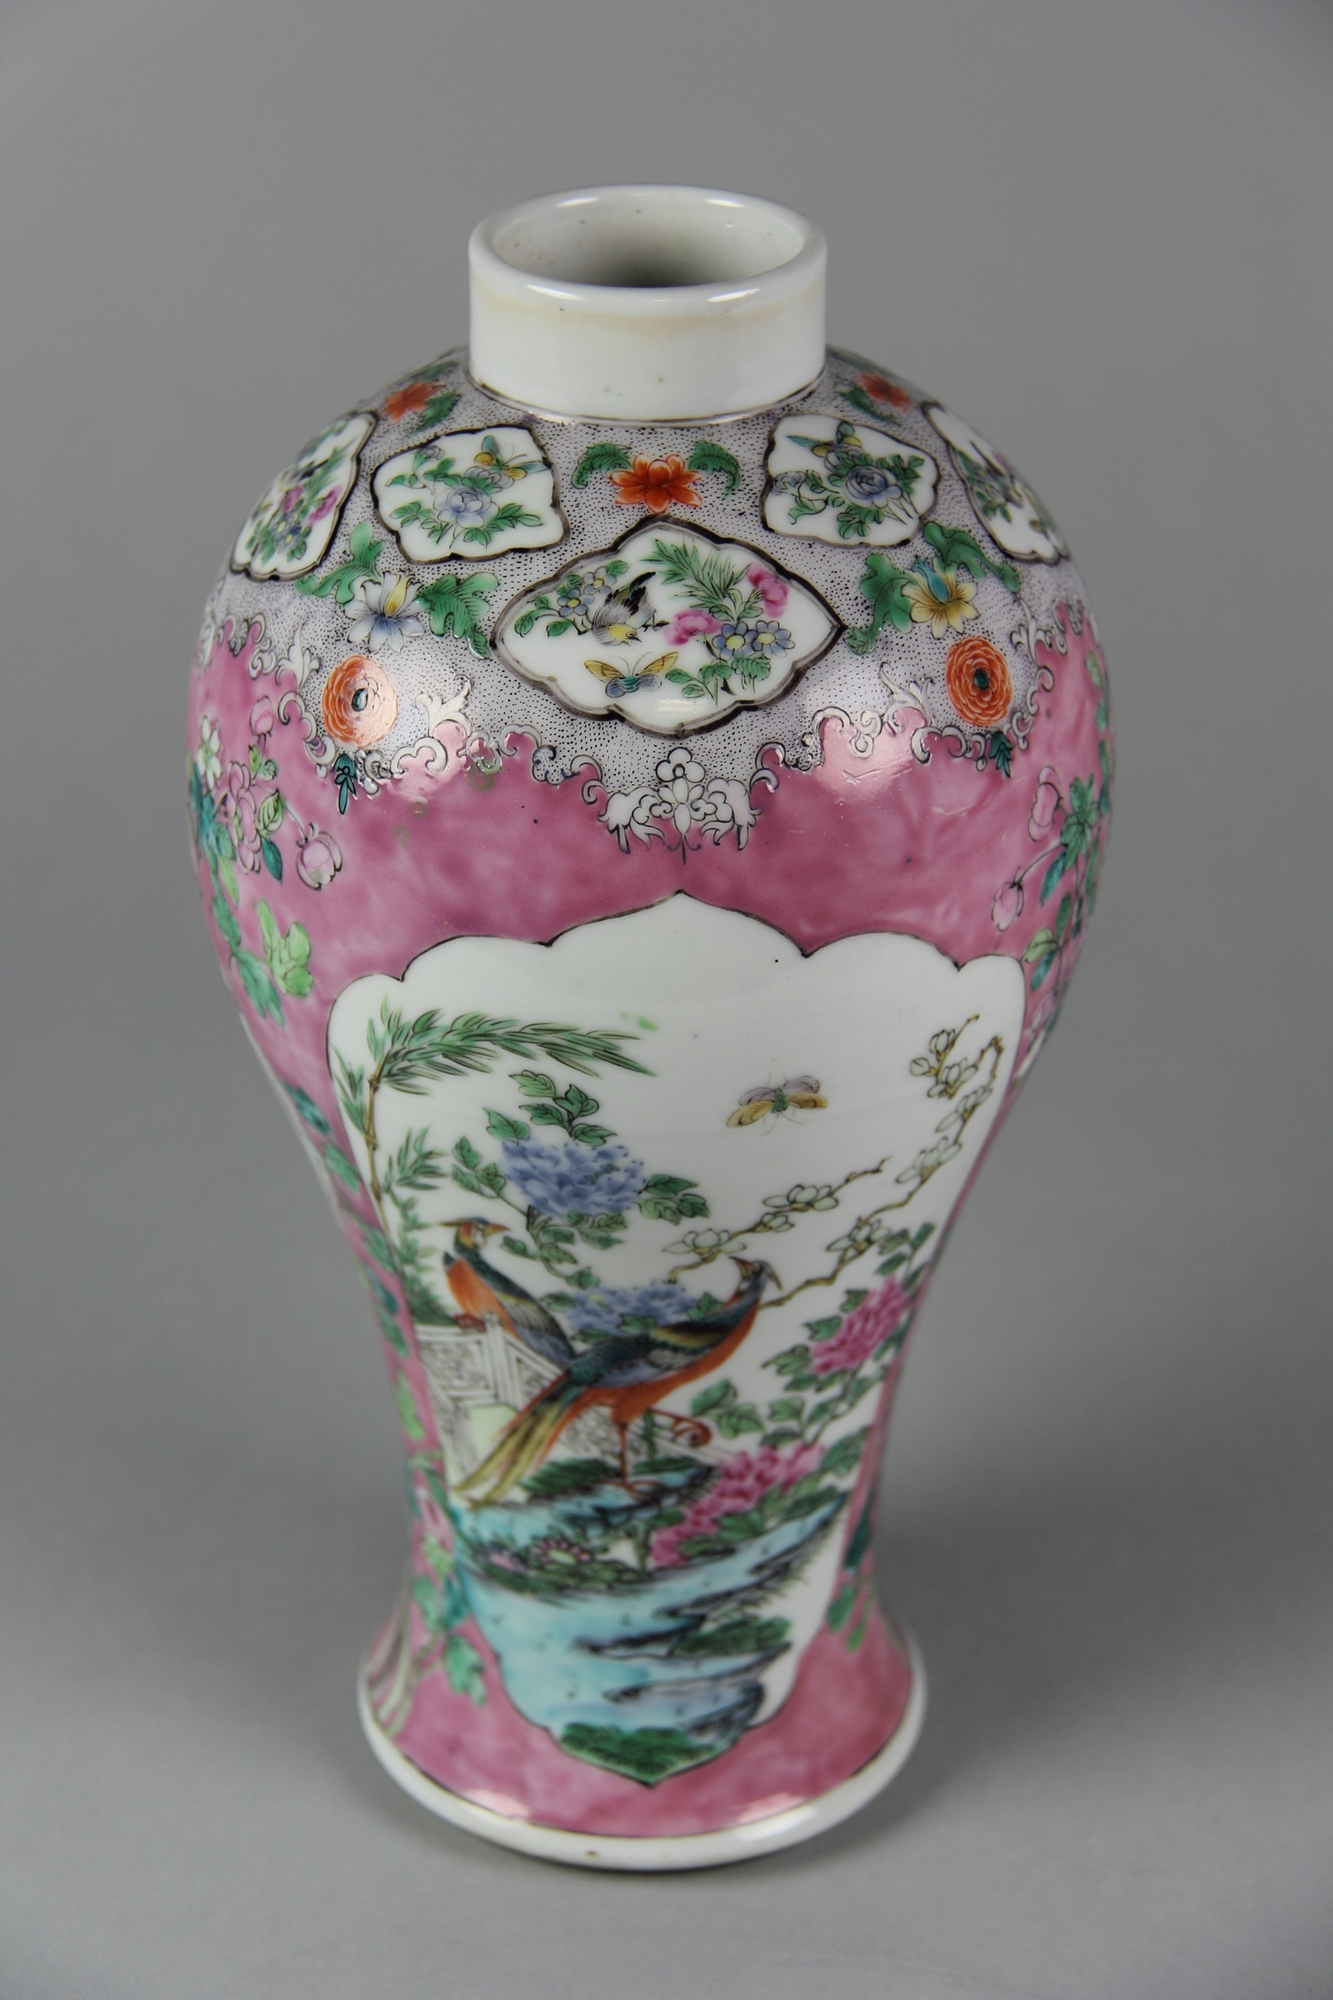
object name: vase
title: Meiping vase with birds and flowers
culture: chinese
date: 1767-1800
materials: enamel, porcelain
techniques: overglaze, painting, polychrome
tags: birds,flowers,leaves